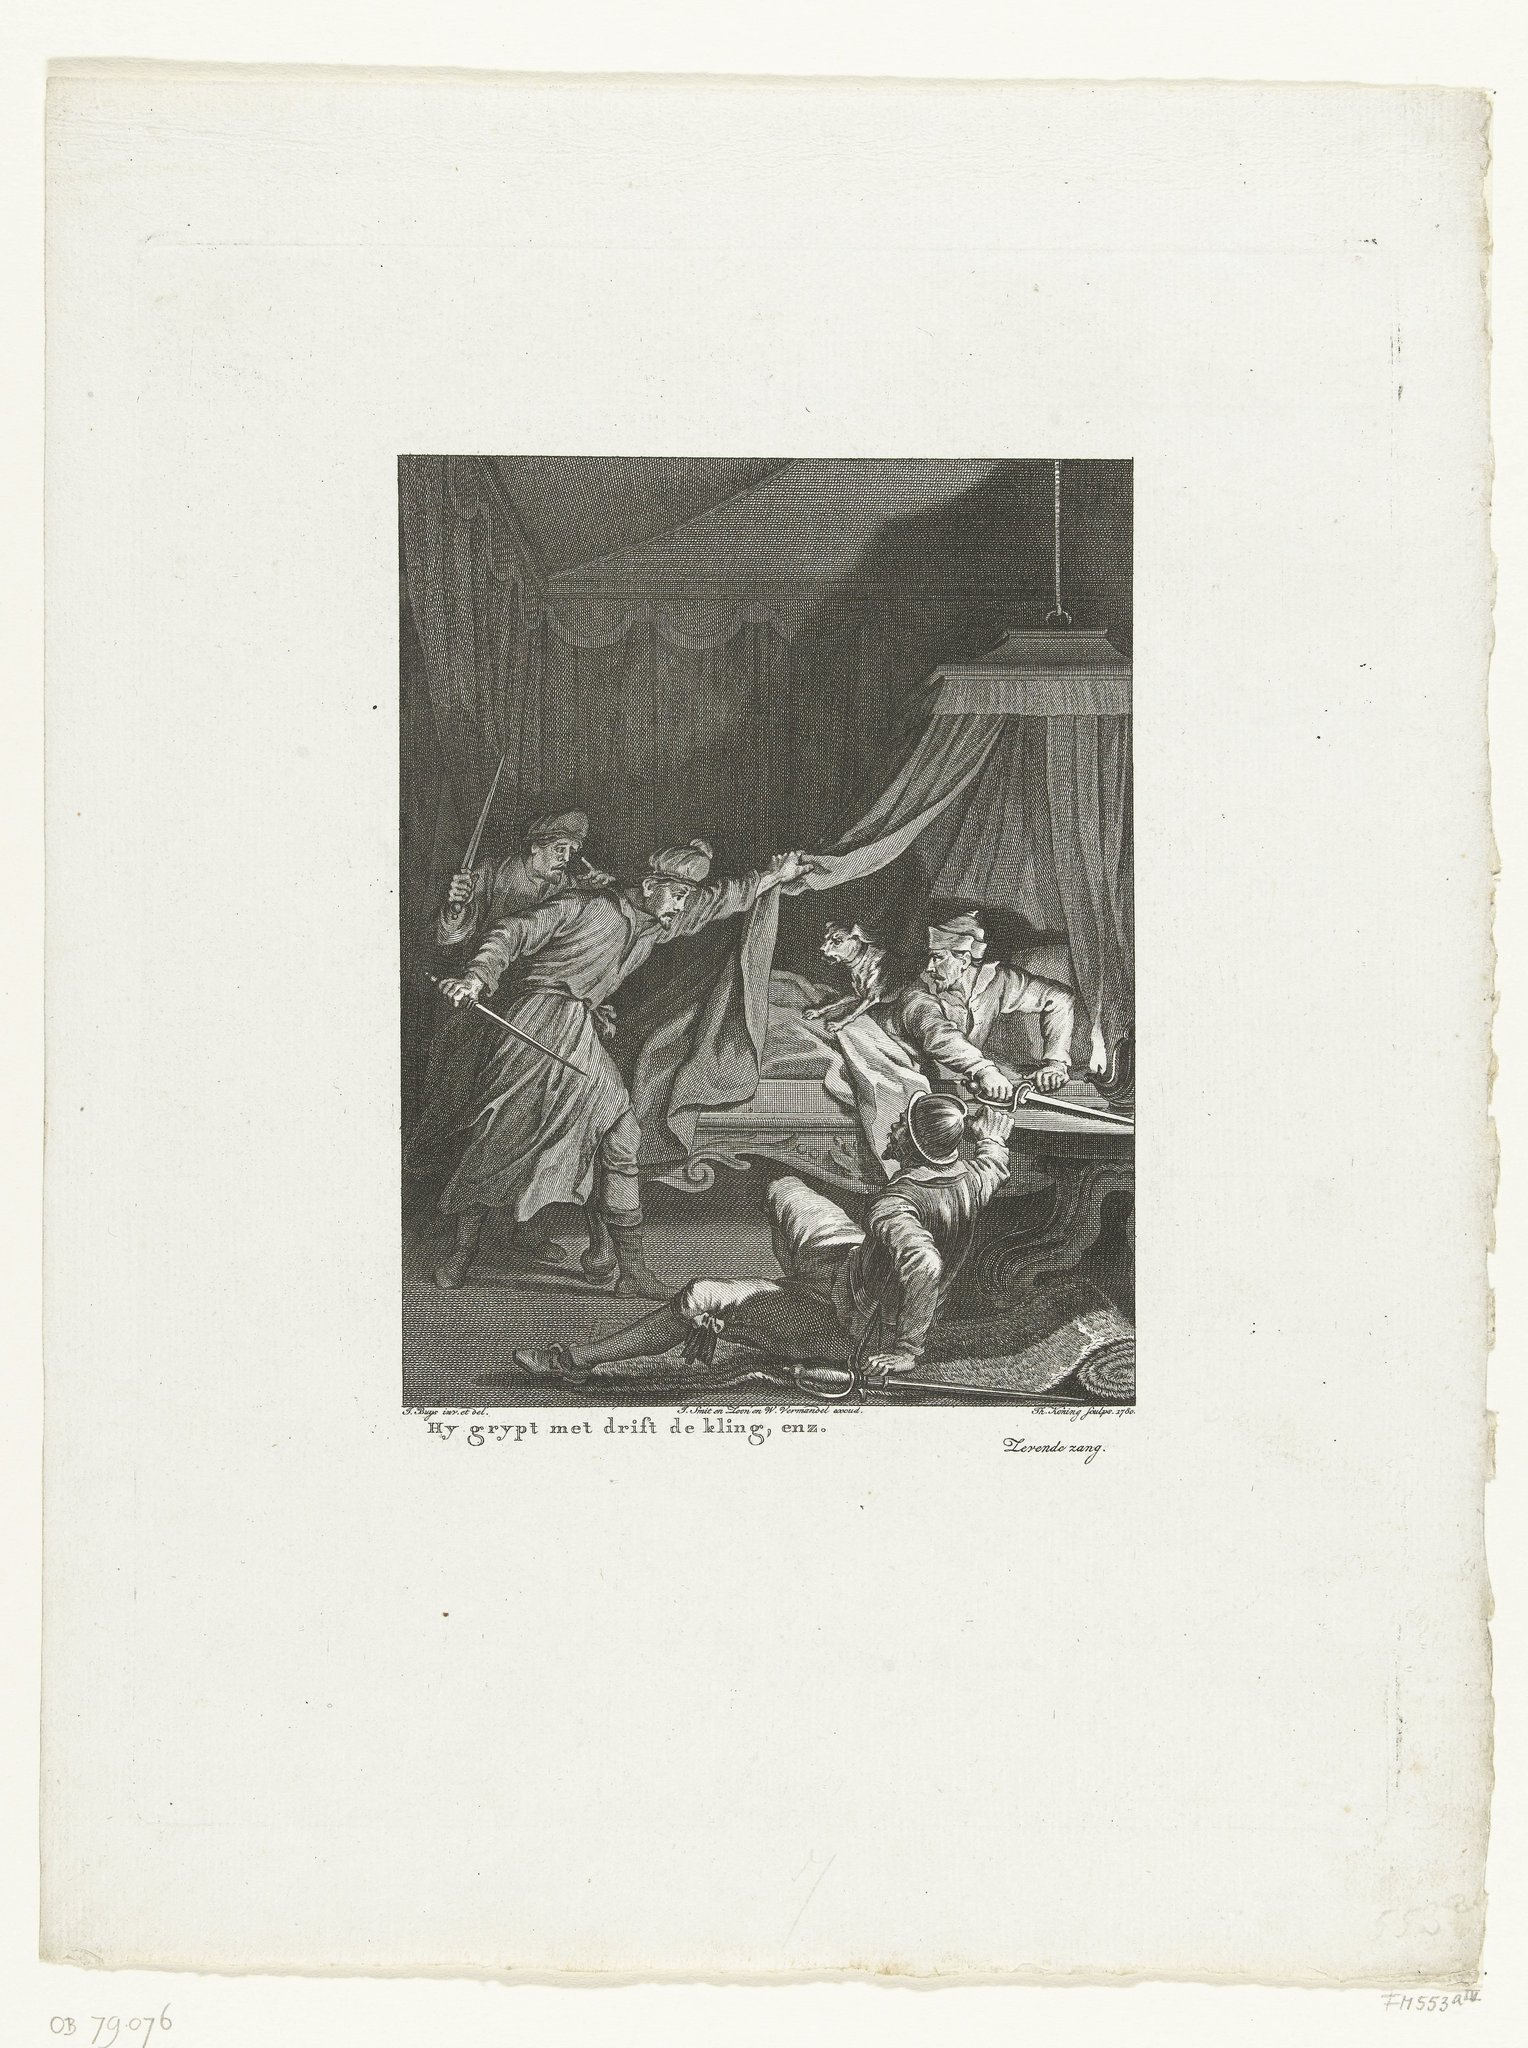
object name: print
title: Mislukte aanslag op de prins van Oranje, 1572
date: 1780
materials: paper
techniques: etching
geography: amsterdam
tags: delft, william i (prince of orange), attempt, political murder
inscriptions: date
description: Illustratie voor: J. Nomsz, Willem de eerste, of de grondlegging der Nederlandsche vryheid. : In vier en twintig zangen, Erven van David Klippink, Amsterdam 1779. Staat met de letter.